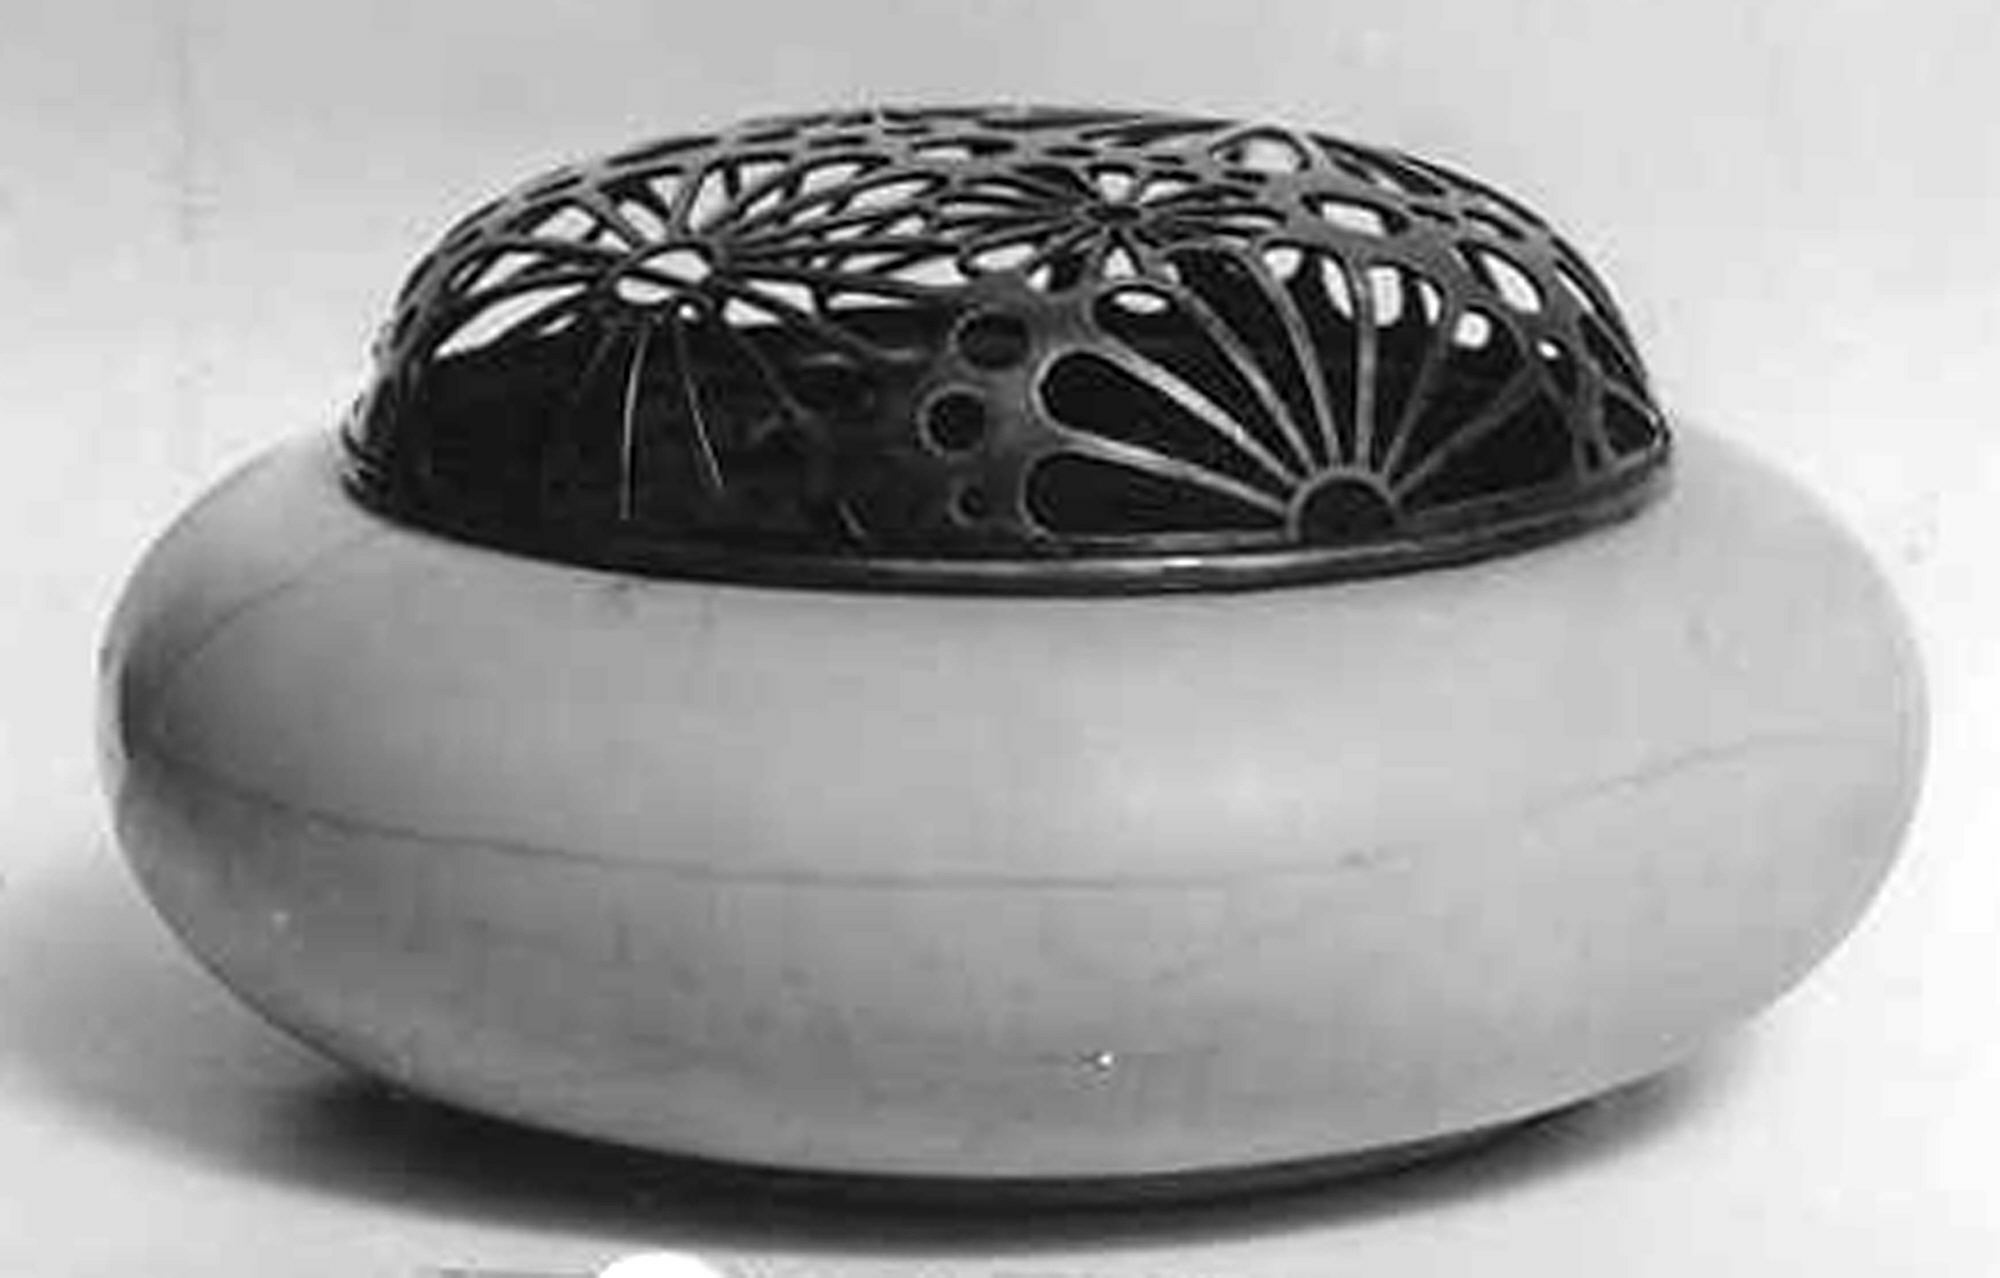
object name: brush washer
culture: chinese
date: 1662-1722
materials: glaze, porcelain